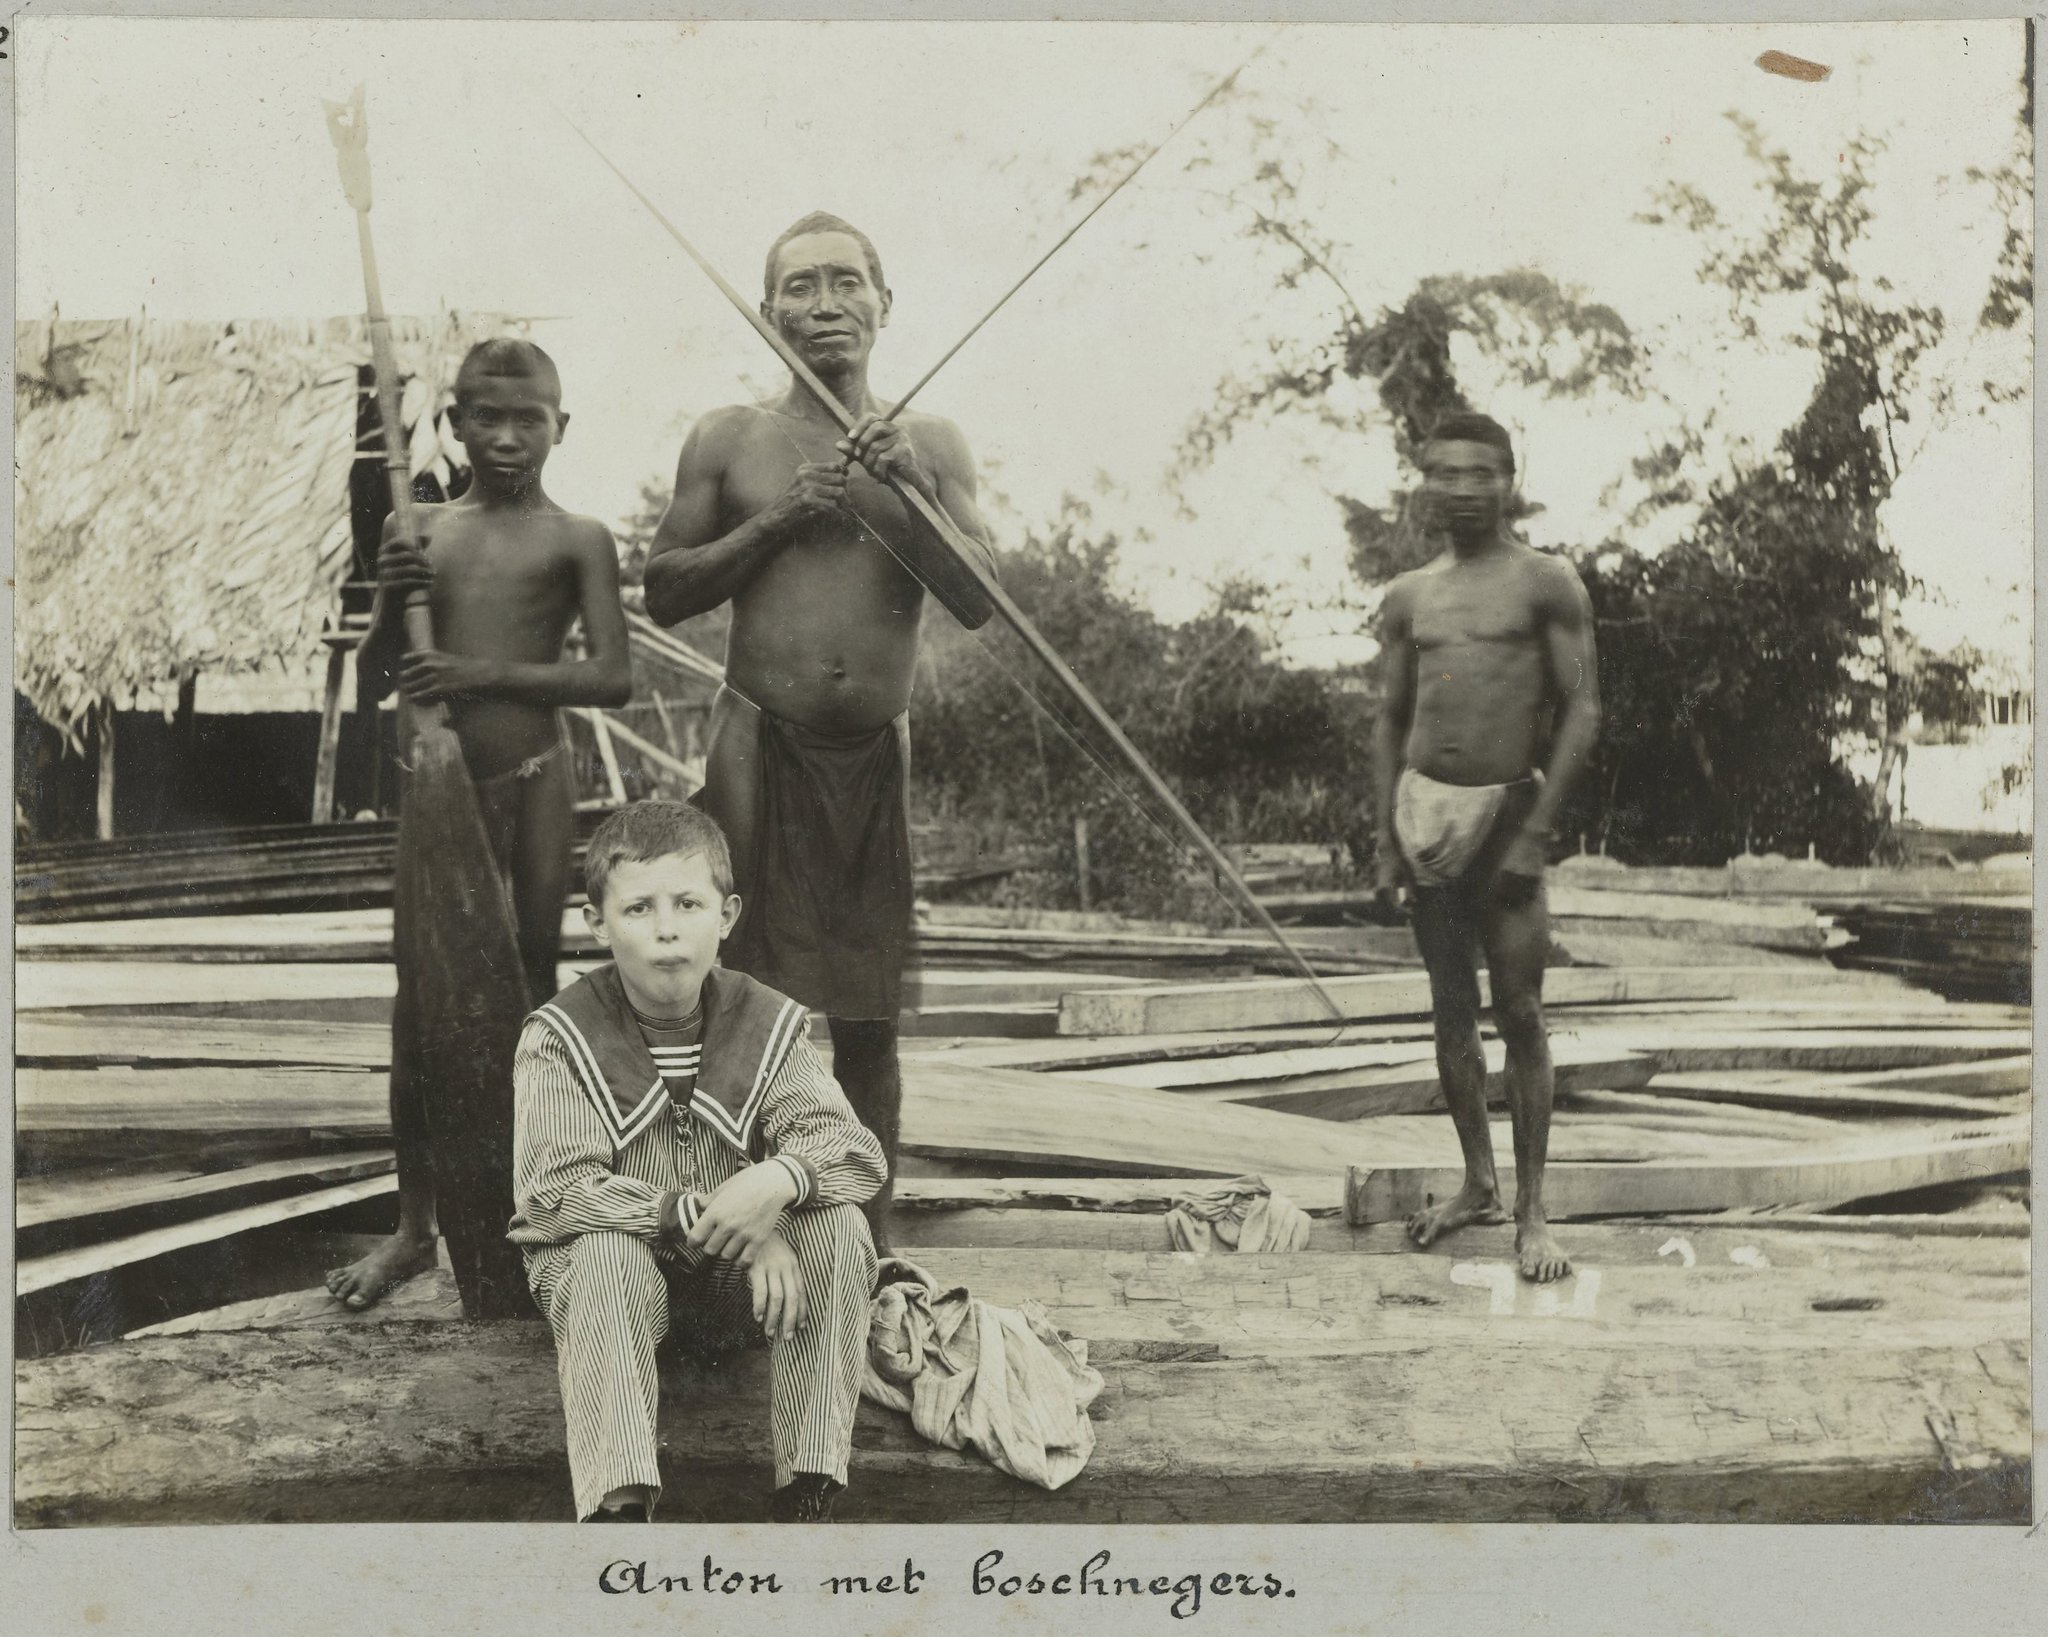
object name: photograph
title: Anton met boschnegers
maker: hendrik doijer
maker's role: engineer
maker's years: 1863-1925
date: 1903-1910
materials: photographic support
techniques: gelatin silver print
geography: suriname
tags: suriname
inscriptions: inscription: ‘B2 / Anton met boschnegers.’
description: Een Nederlandse jongen Anton zittend poserend voor een groep van drie Marrons, met roeispaan en pijl en boog. Onderdeel van het fotoalbum Souvenir de Voyage (deel 1), over het leven van de familie Doijer in en rond de plantage Ma Retraite in Suriname in de jaren 1903-1910.